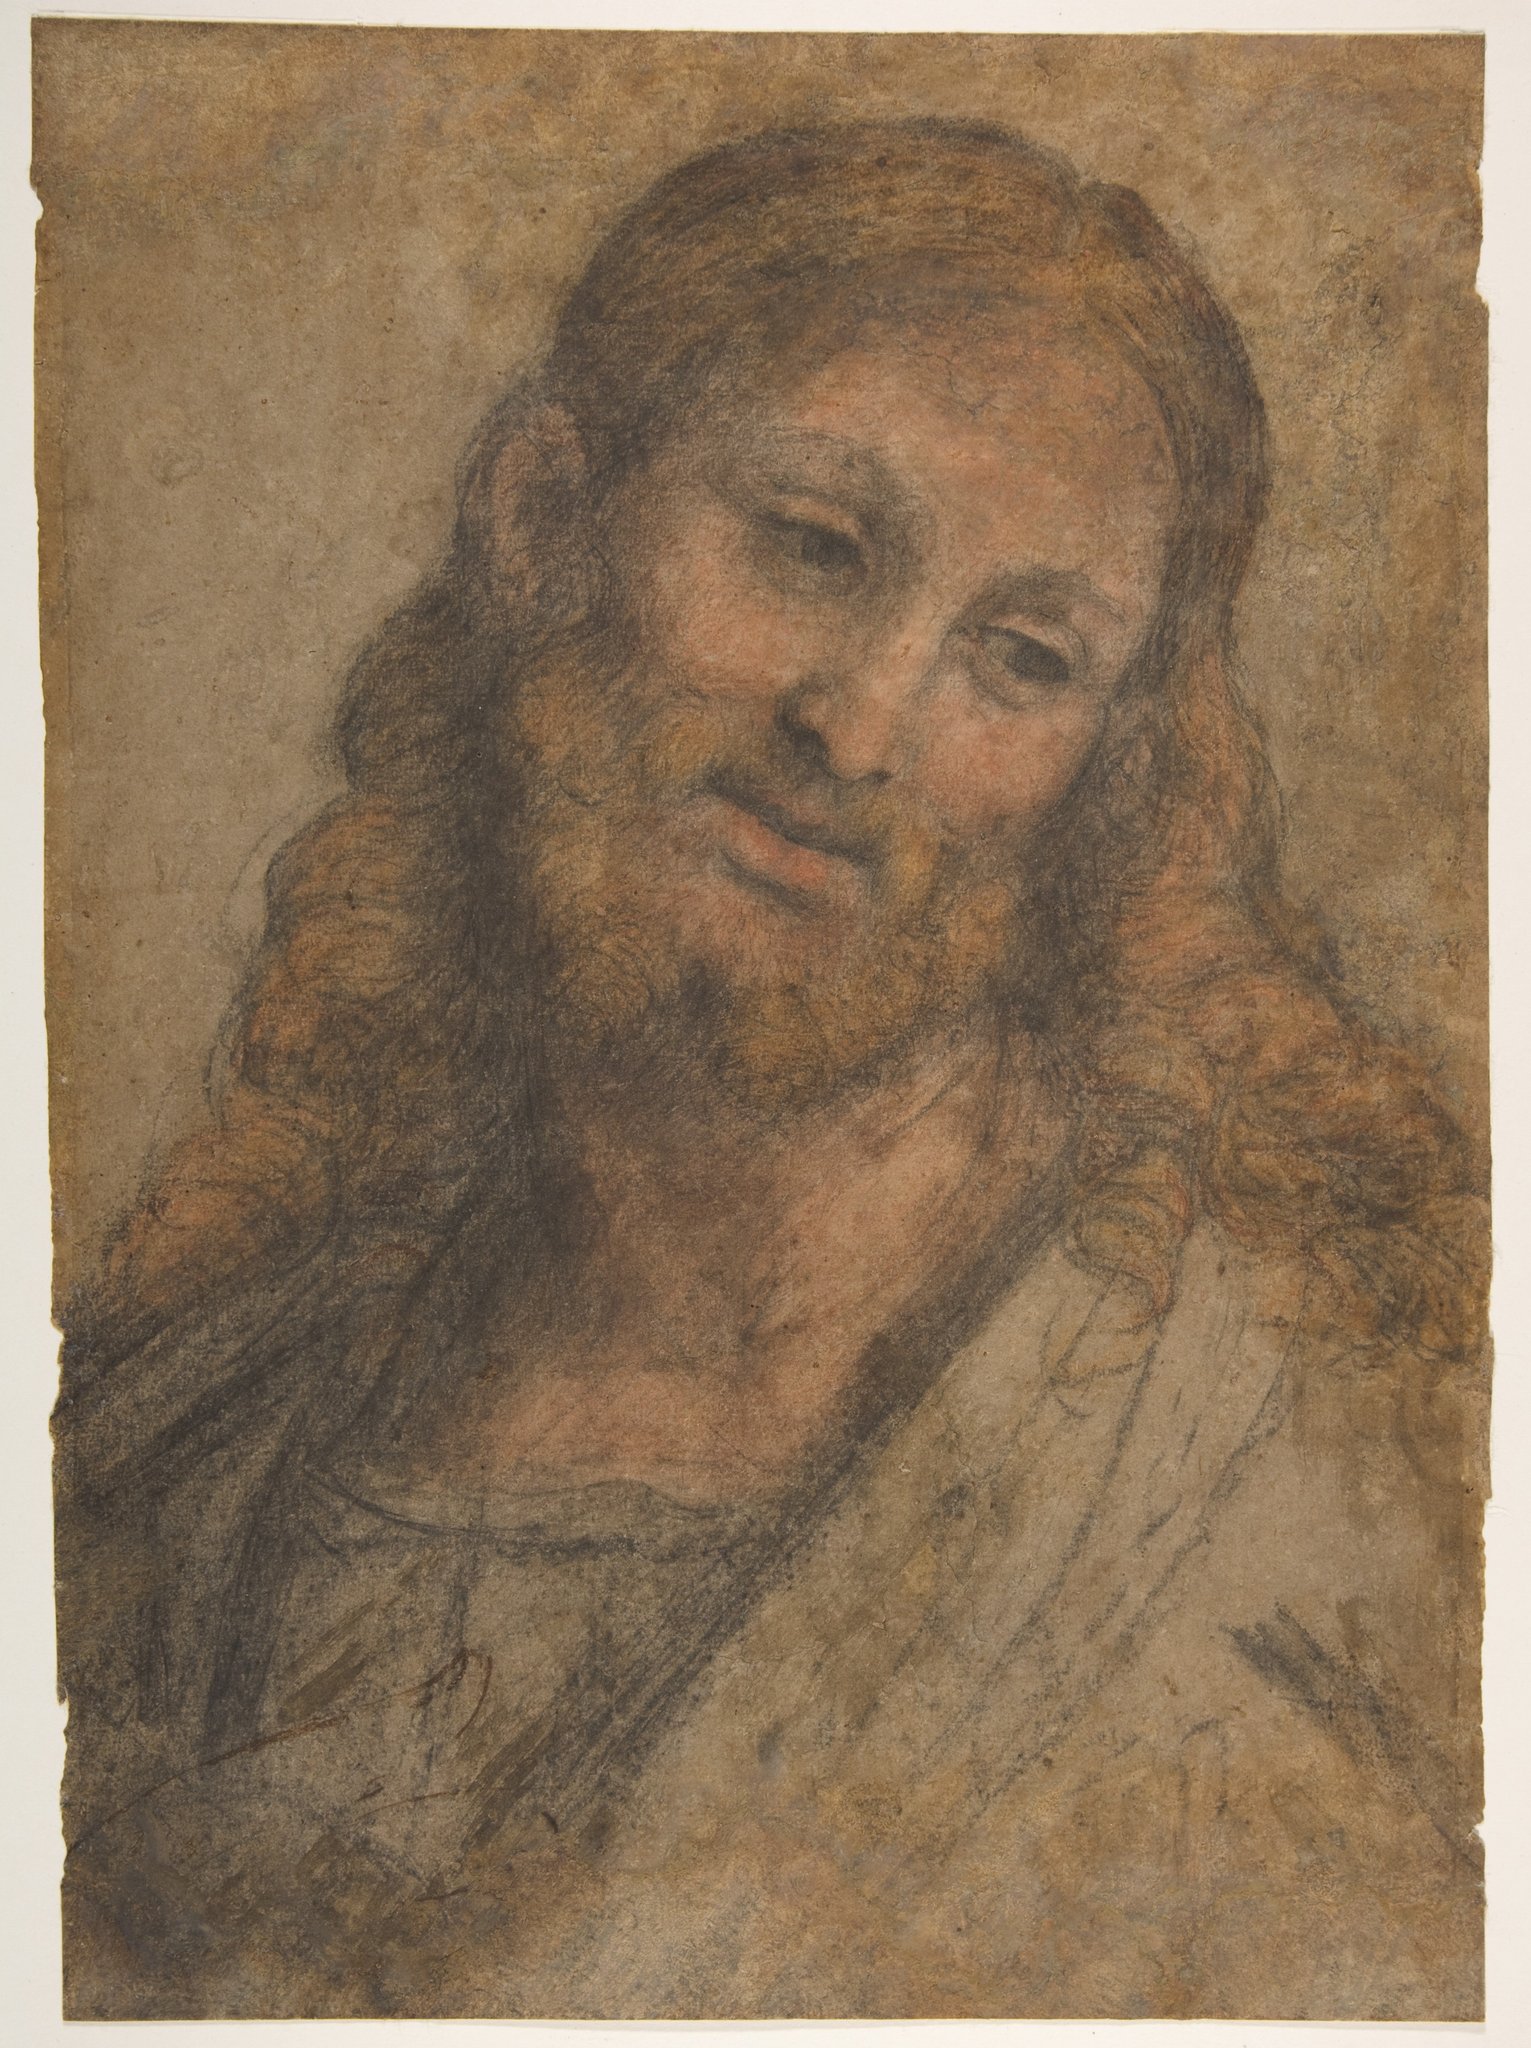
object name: drawing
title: Bust of a Bearded Figure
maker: andrea solario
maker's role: artist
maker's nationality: italian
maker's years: 1465-1524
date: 1515-1524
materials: chalk, paper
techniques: drawing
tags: men